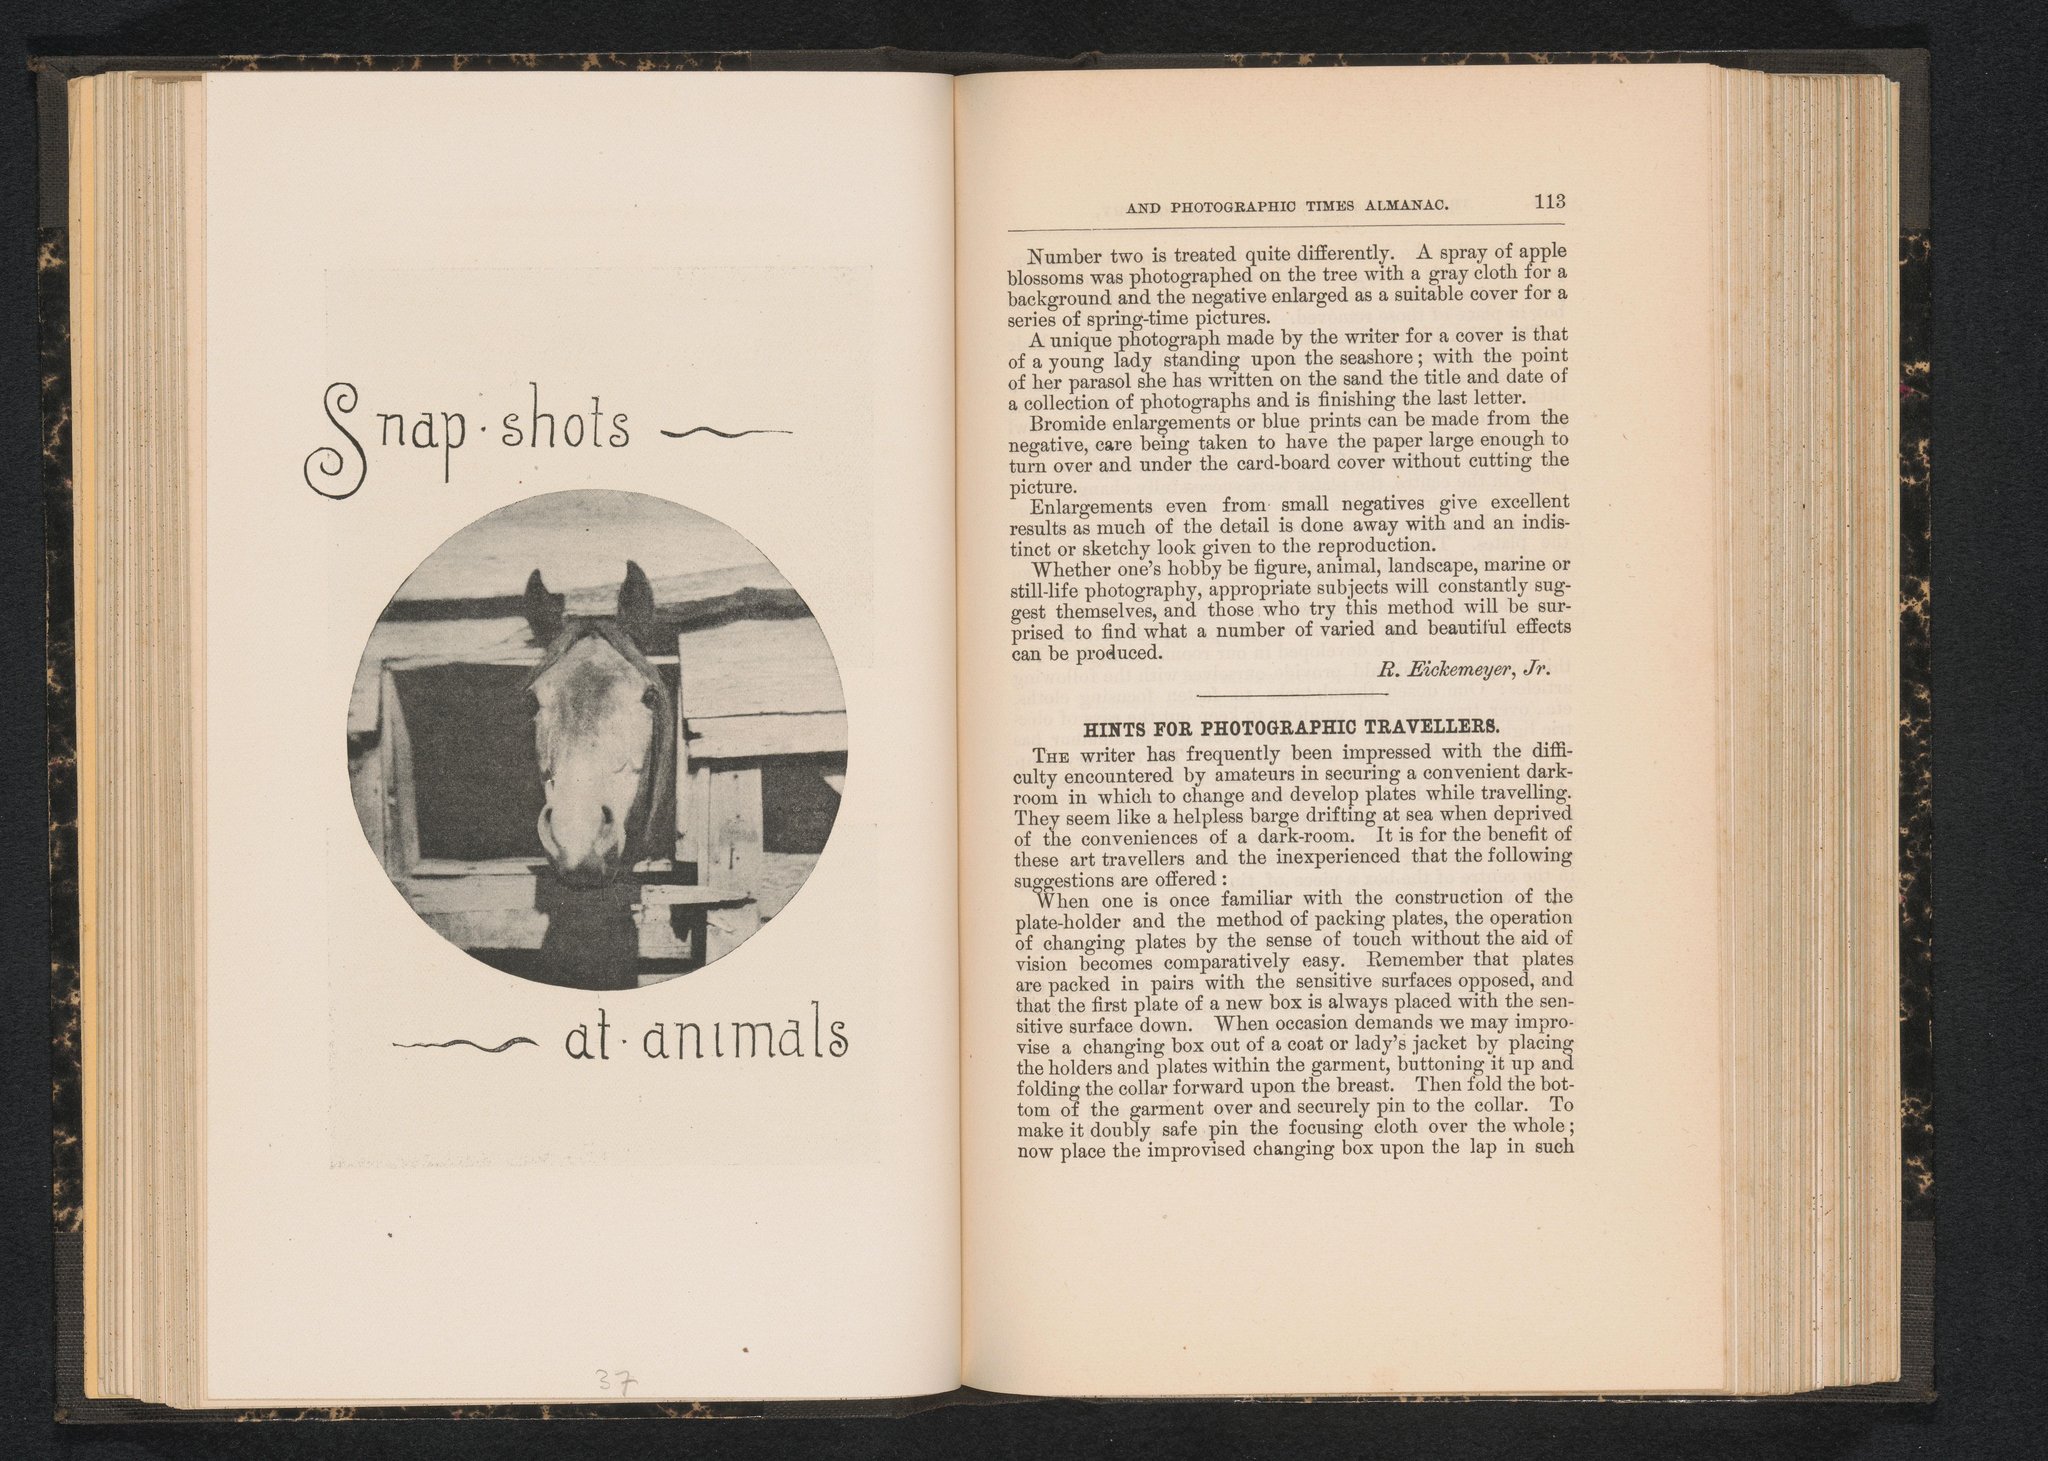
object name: photomechanical print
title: En face van een paard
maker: Anonymous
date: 1887-1907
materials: paper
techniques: autotype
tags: horse